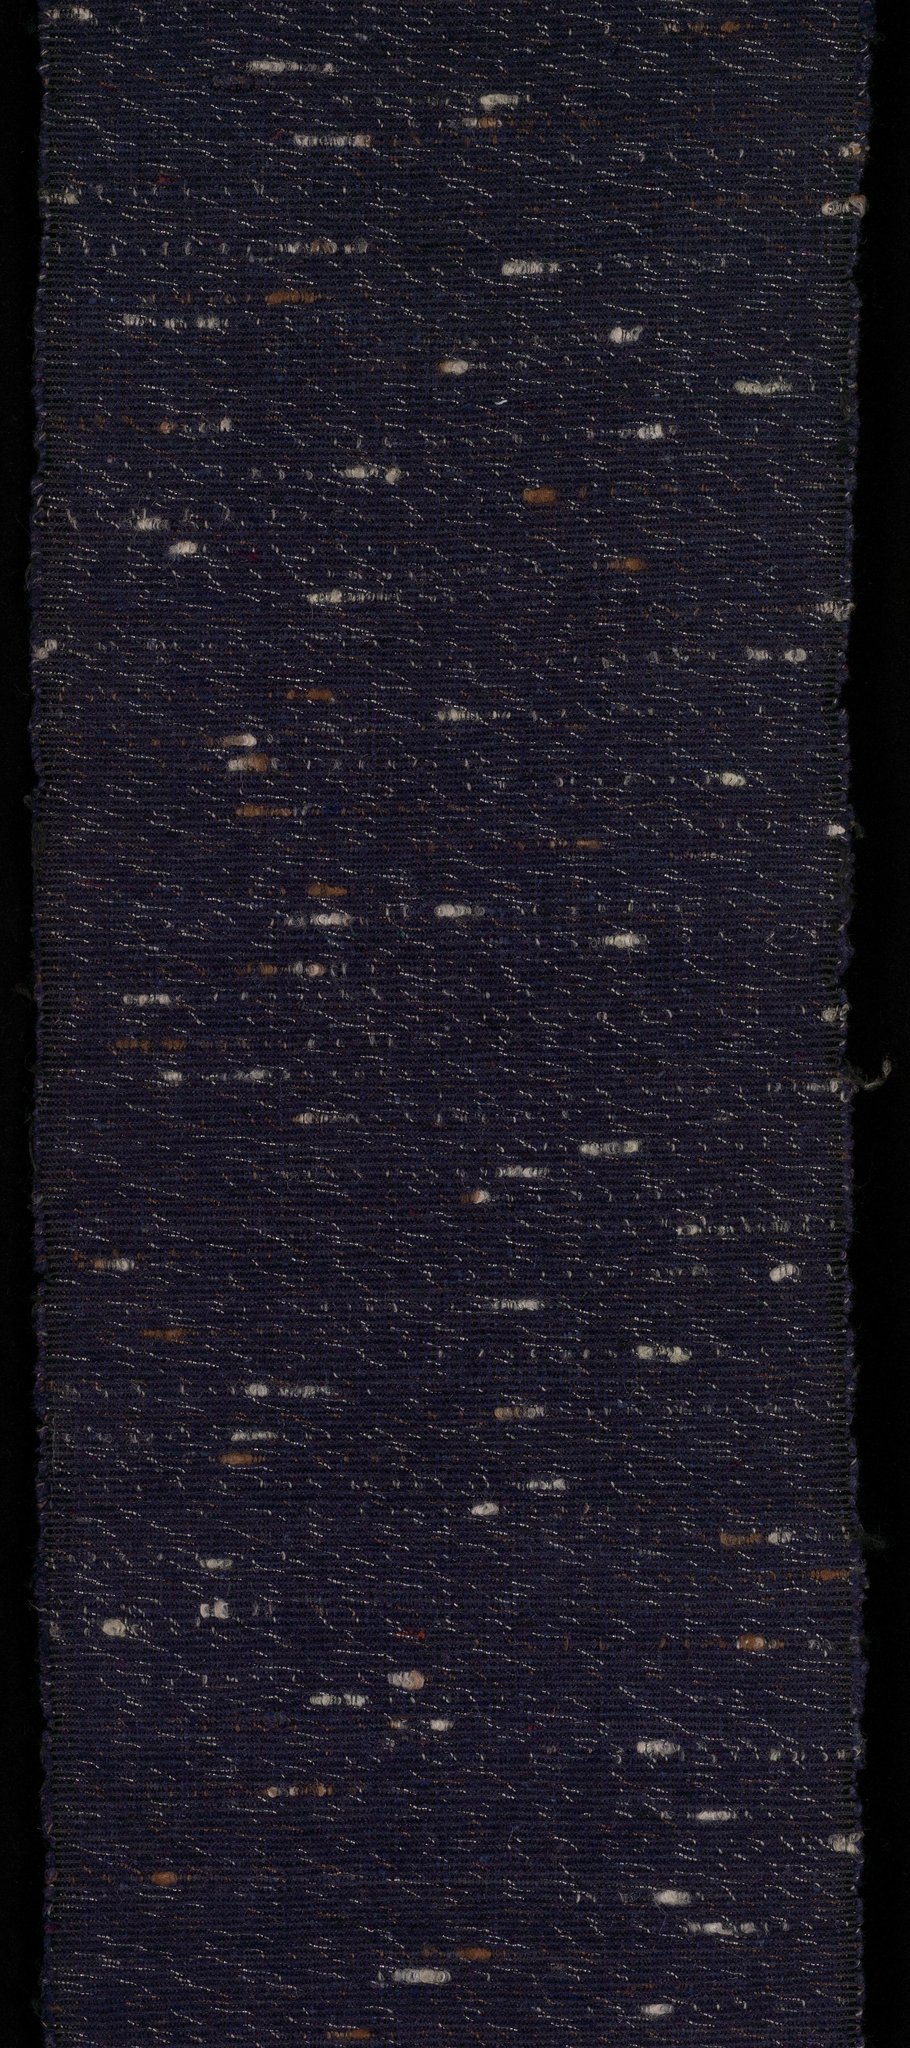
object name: obi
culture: japanese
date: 1912-1926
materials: cotton